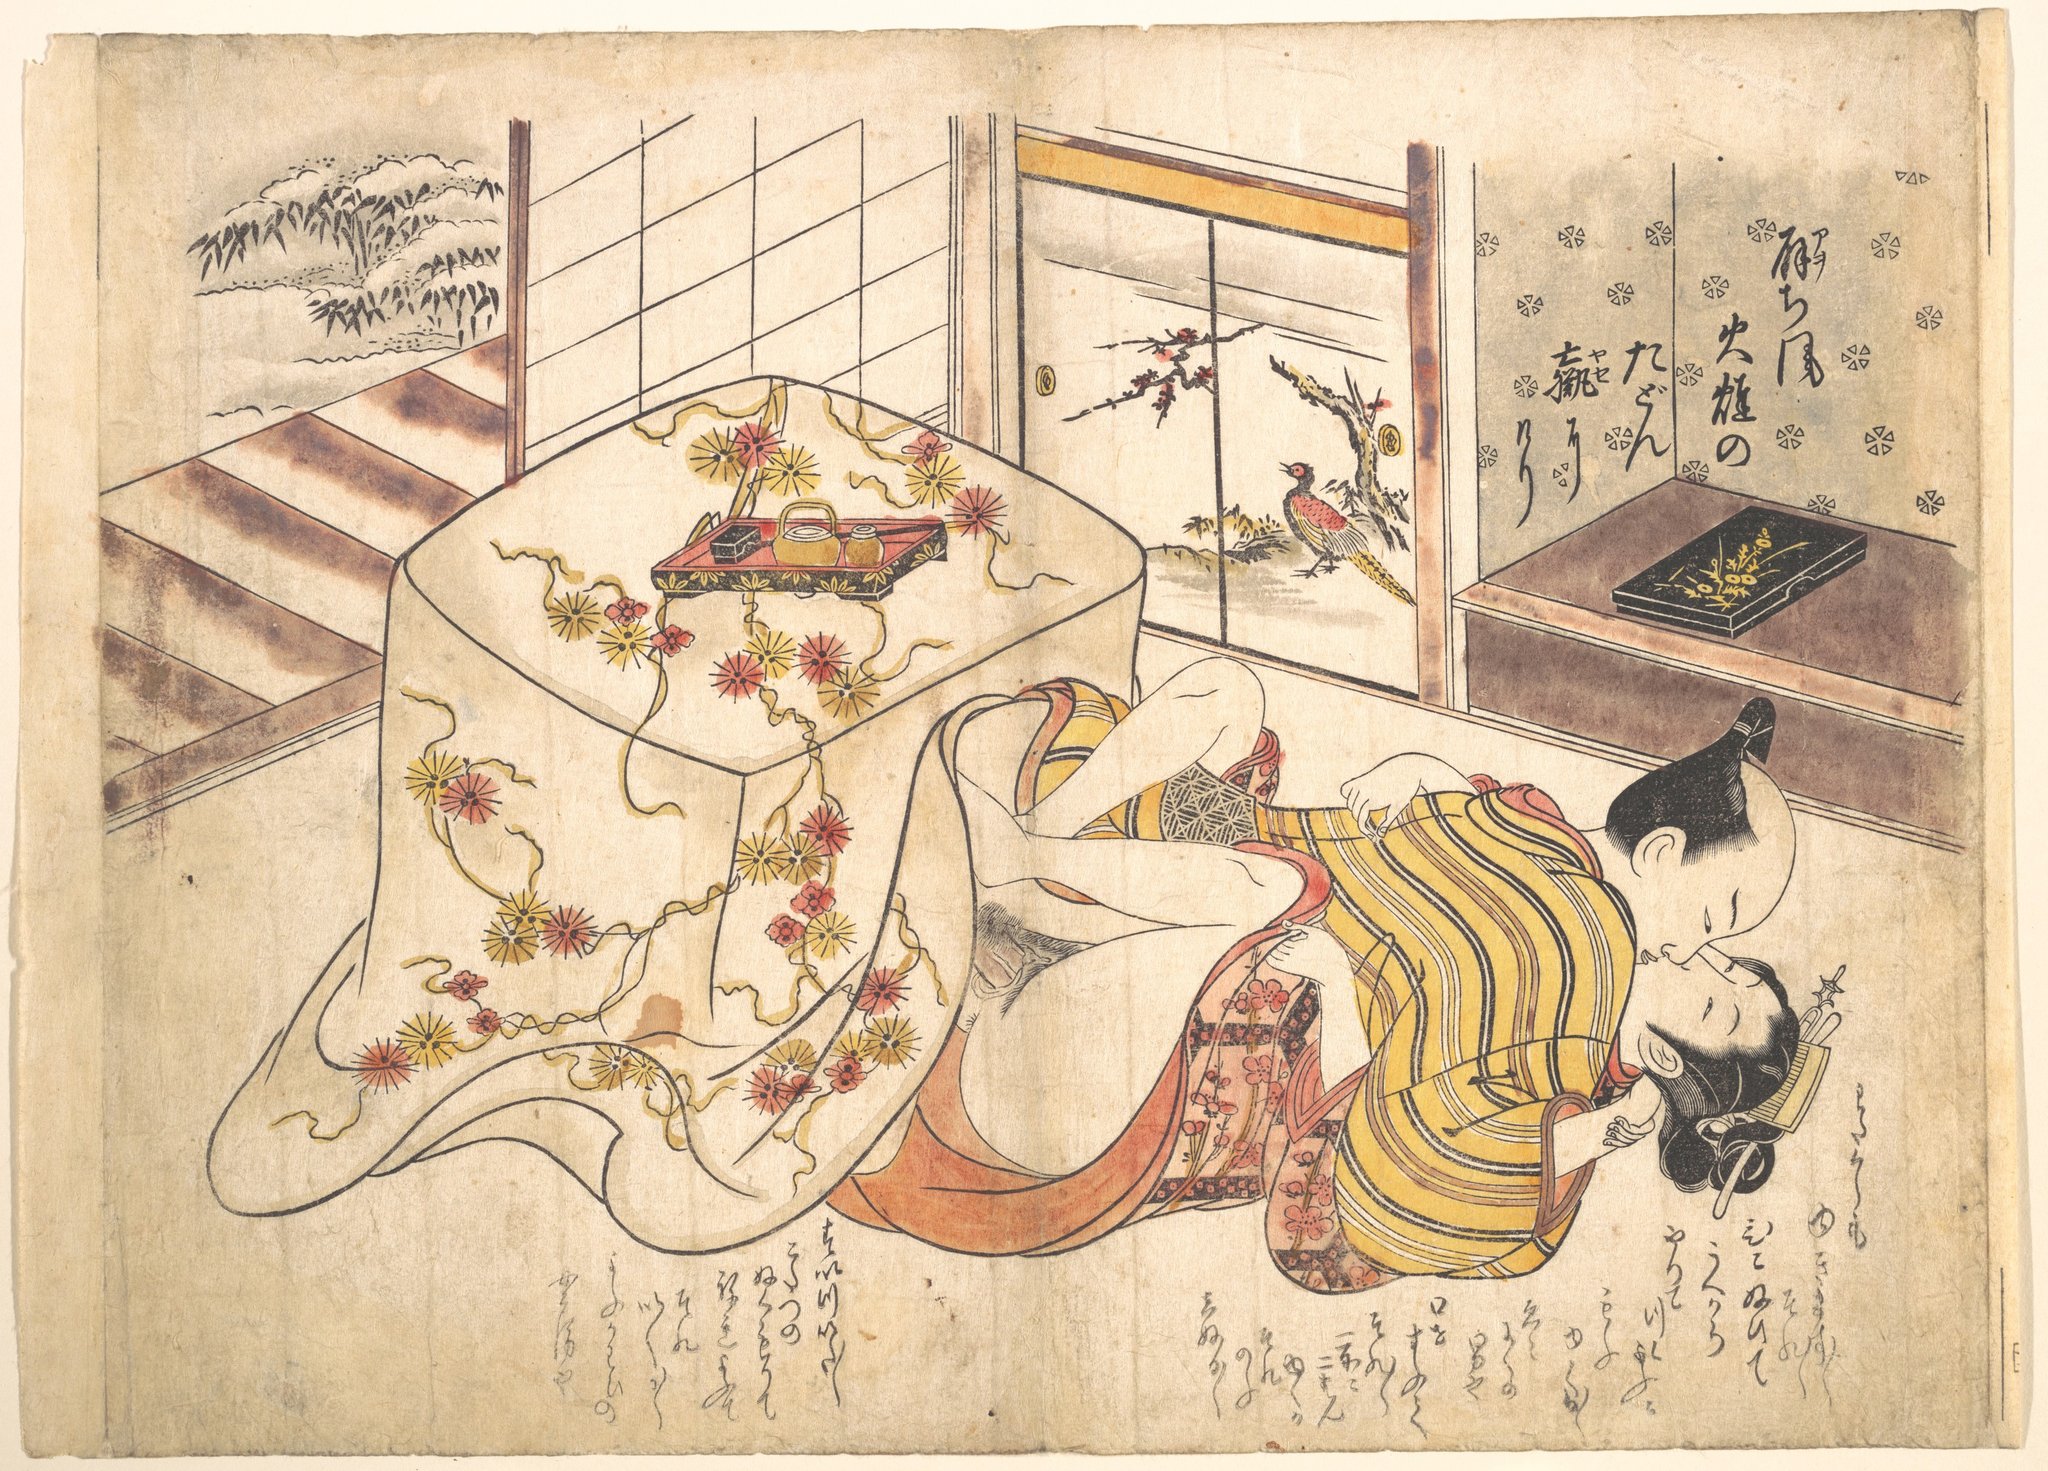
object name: print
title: Bedroom Scene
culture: japanese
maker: okumura masanobu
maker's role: artist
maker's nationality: japanese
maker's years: 1686-1764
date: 1739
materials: ink, paper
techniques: hand coloring, woodblock print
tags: bedrooms,couples,male nudes,female nudes